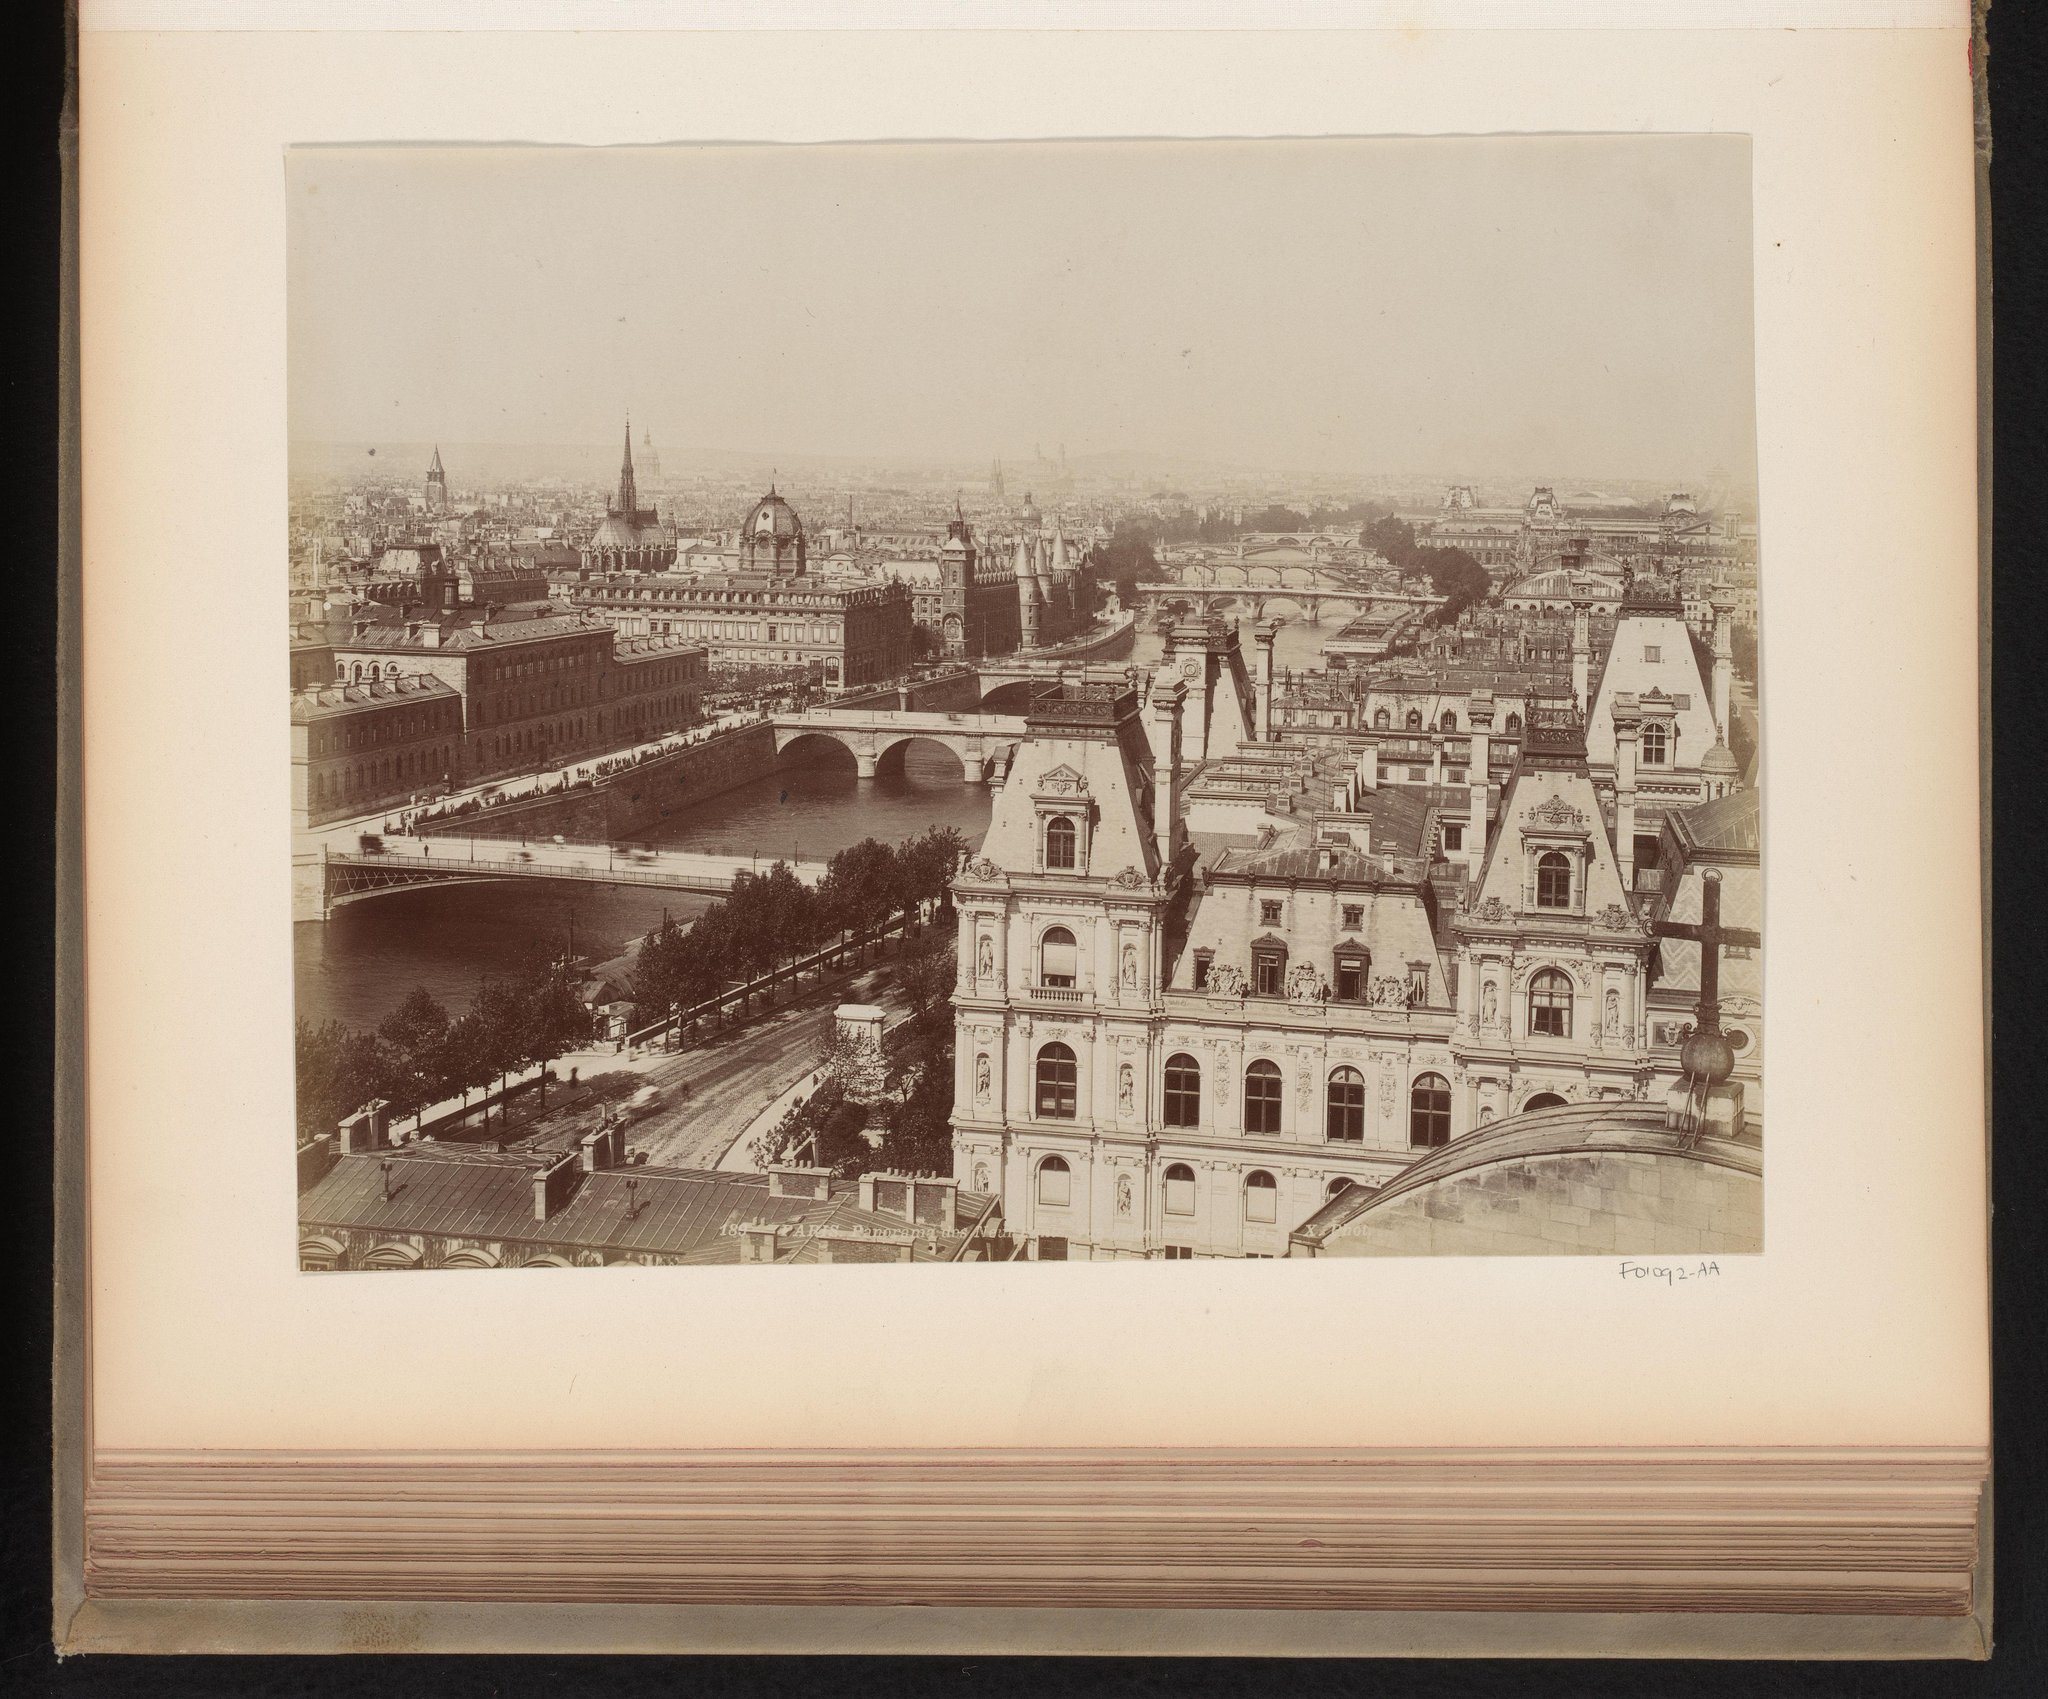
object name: photograph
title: PARIS. Panorama des neuf Ponts (...)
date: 1880-1900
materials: cardboard, paper, photographic support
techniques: albumen print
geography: paris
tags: bridge in city across river, canal, etc., prospect of city, town panorama, silhouette of city, paris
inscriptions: negative number: ‘189’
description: Onderdeel van Reisalbum met foto's van bezienswaardigheden in België en Frankrijk.